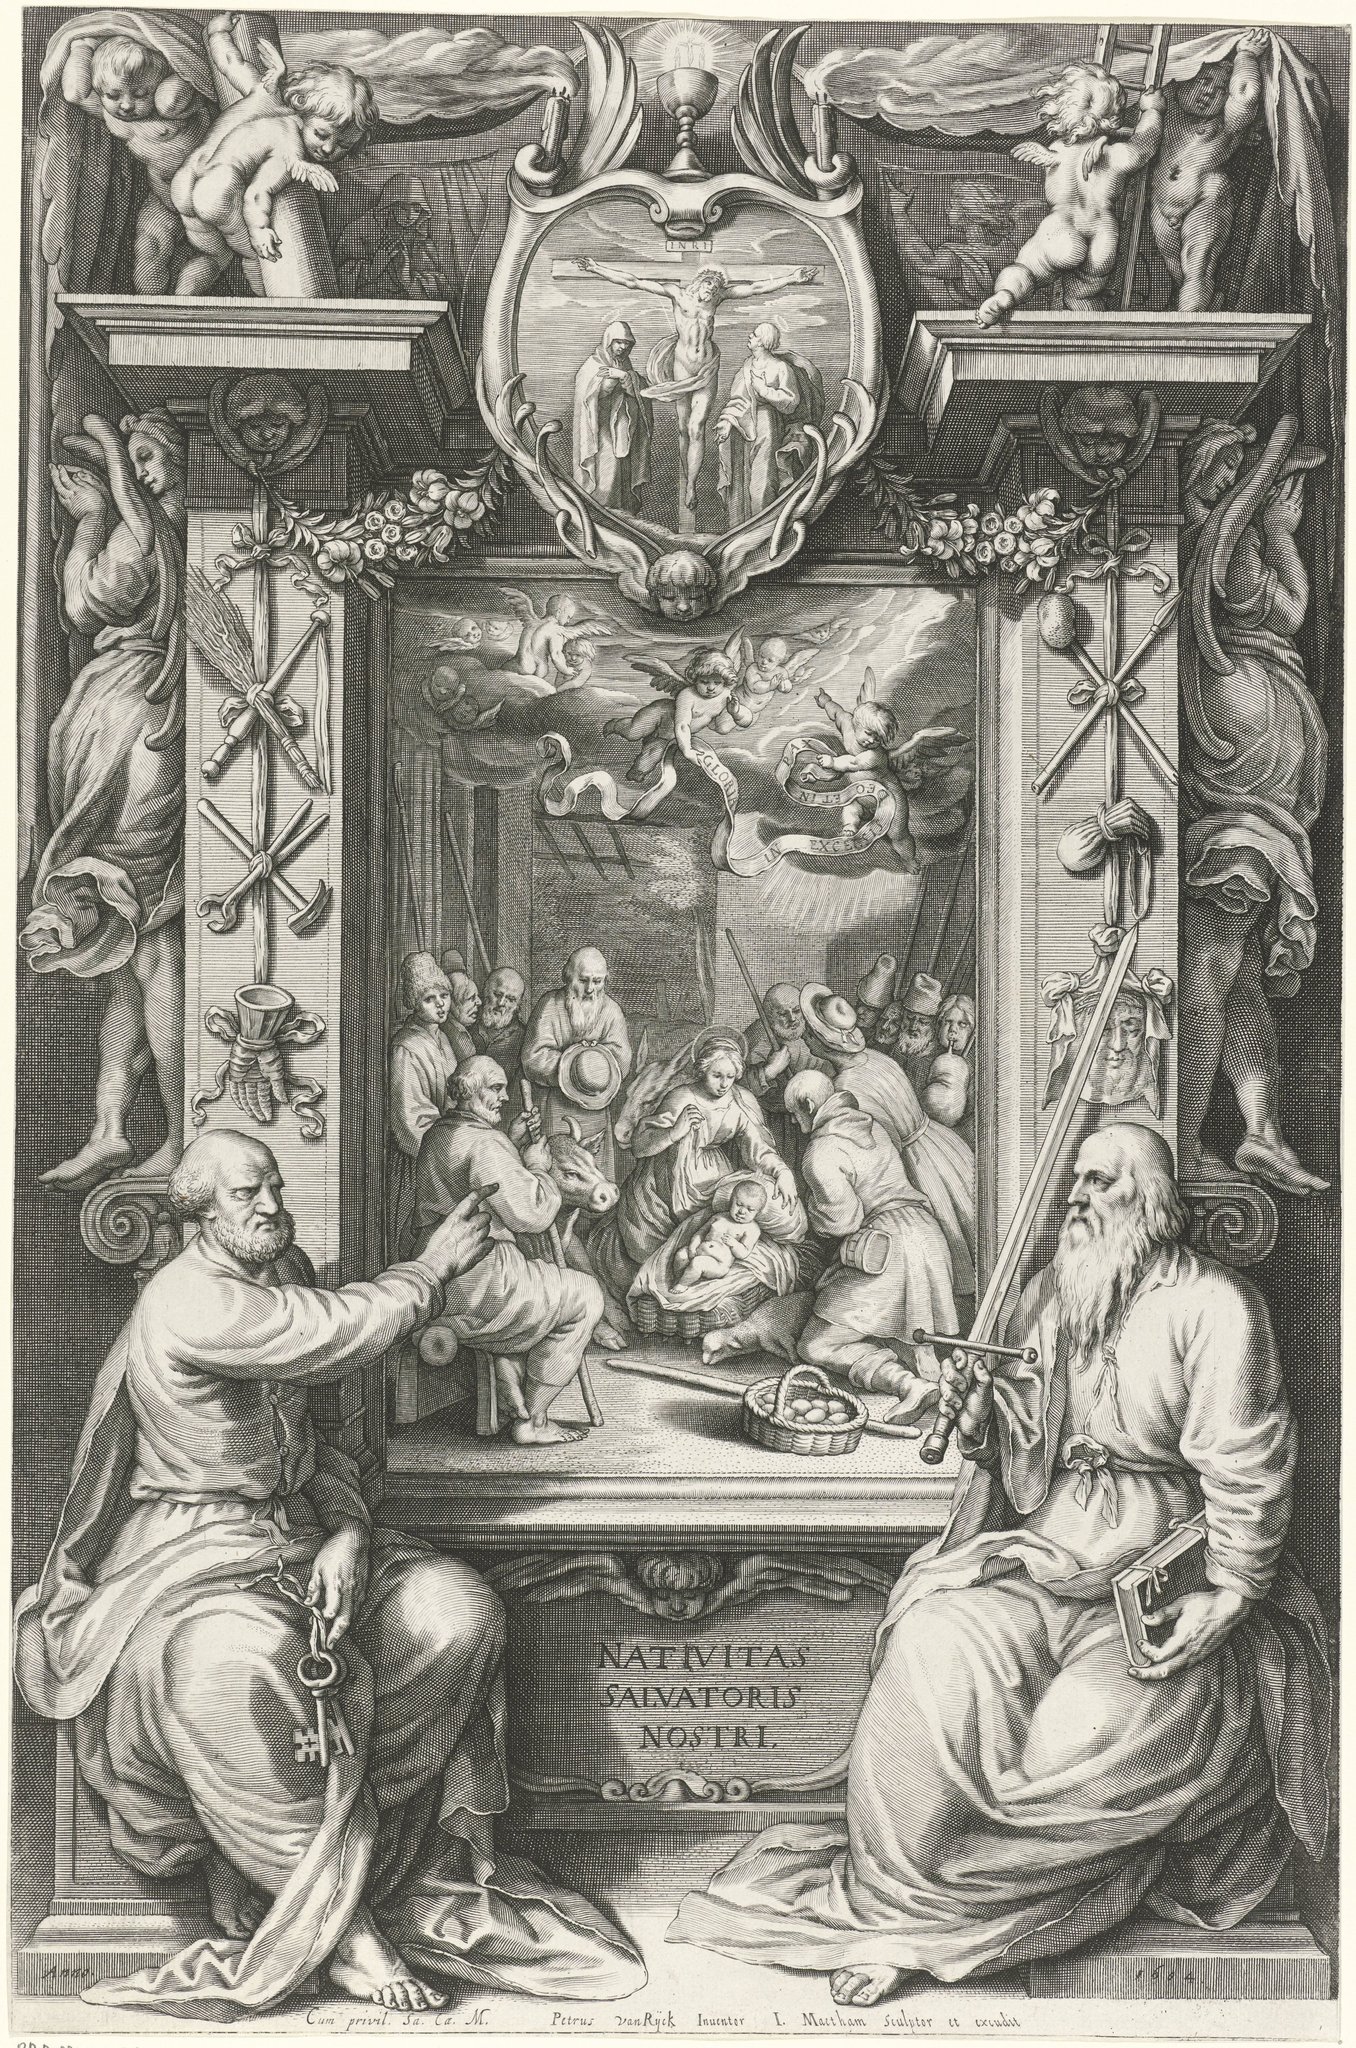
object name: print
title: Geboorte van Christus, met Petrus en Paulus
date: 1604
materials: paper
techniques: engraving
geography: haarlem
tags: adoration of the christ-child by the shepherds; mary and joseph present, single instruments of the passion, the apostle peter, first bishop of rome; possible attributes: book, cock, (upturned) cross, (triple) crozier, fish, key, scroll, ship, tiara, mary, joseph and the new-born christ (nativity), the apostle paul of tarsus; possible attributes: book, scroll, sword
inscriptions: collector's mark: Lugt 240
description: De geboorte van Christus met knielende herder in een ornamenteel architectonische omlijsting, waarop aan weerskanten de passiewerktuigen. Daarboven in een cartouche een afbeelding van de kruisiging. Op de voorgrond aan weerszijden van de omlijsting de apostel Petrus met zijn sleutels en de apostel Paulus met zijn zwaard en boek.